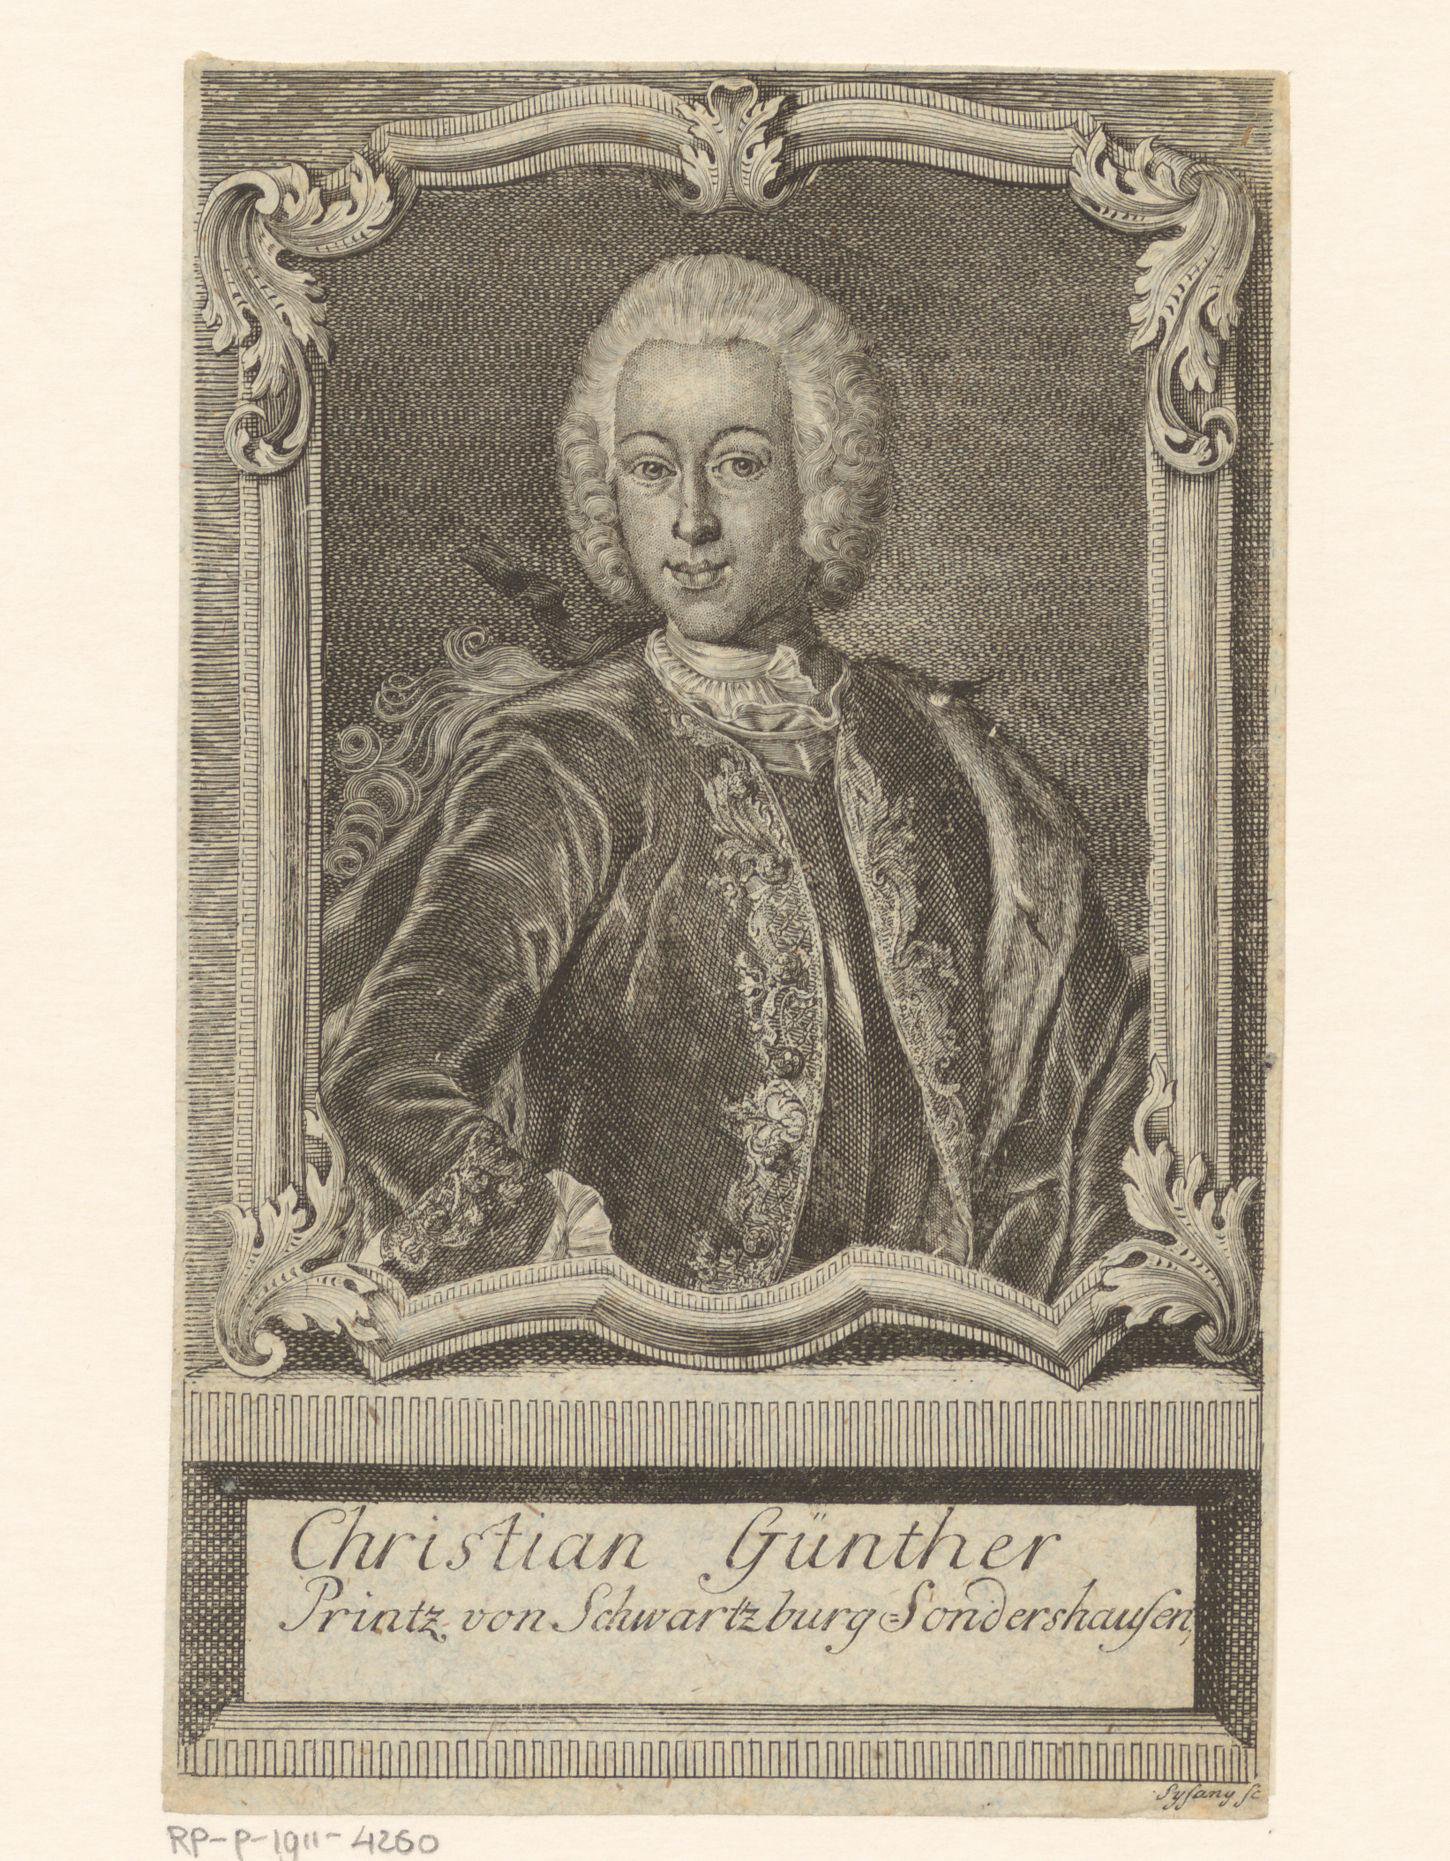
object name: print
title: Portret van Christian Günther II von Schwarzburg-Sondershausen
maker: johann christoph sysang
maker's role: print maker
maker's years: 1703-1757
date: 1713-1757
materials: paper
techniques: engraving, etching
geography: germany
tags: historical persons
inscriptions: collector's mark: Lugt 2228